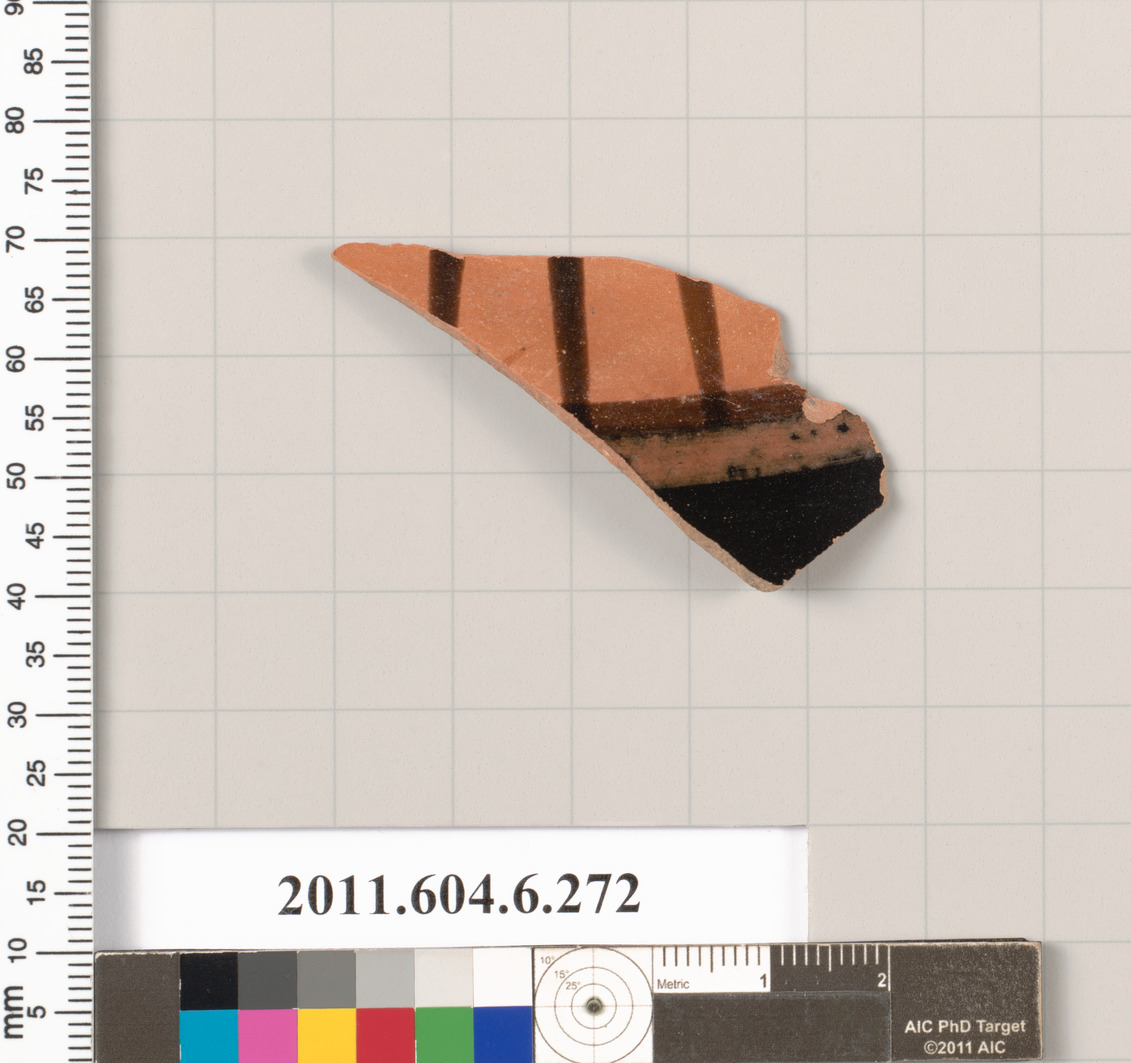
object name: lekanis fragment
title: Terracotta fragment of a lekanis (dish)?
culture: greek, attic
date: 600-501 BCE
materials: terracotta